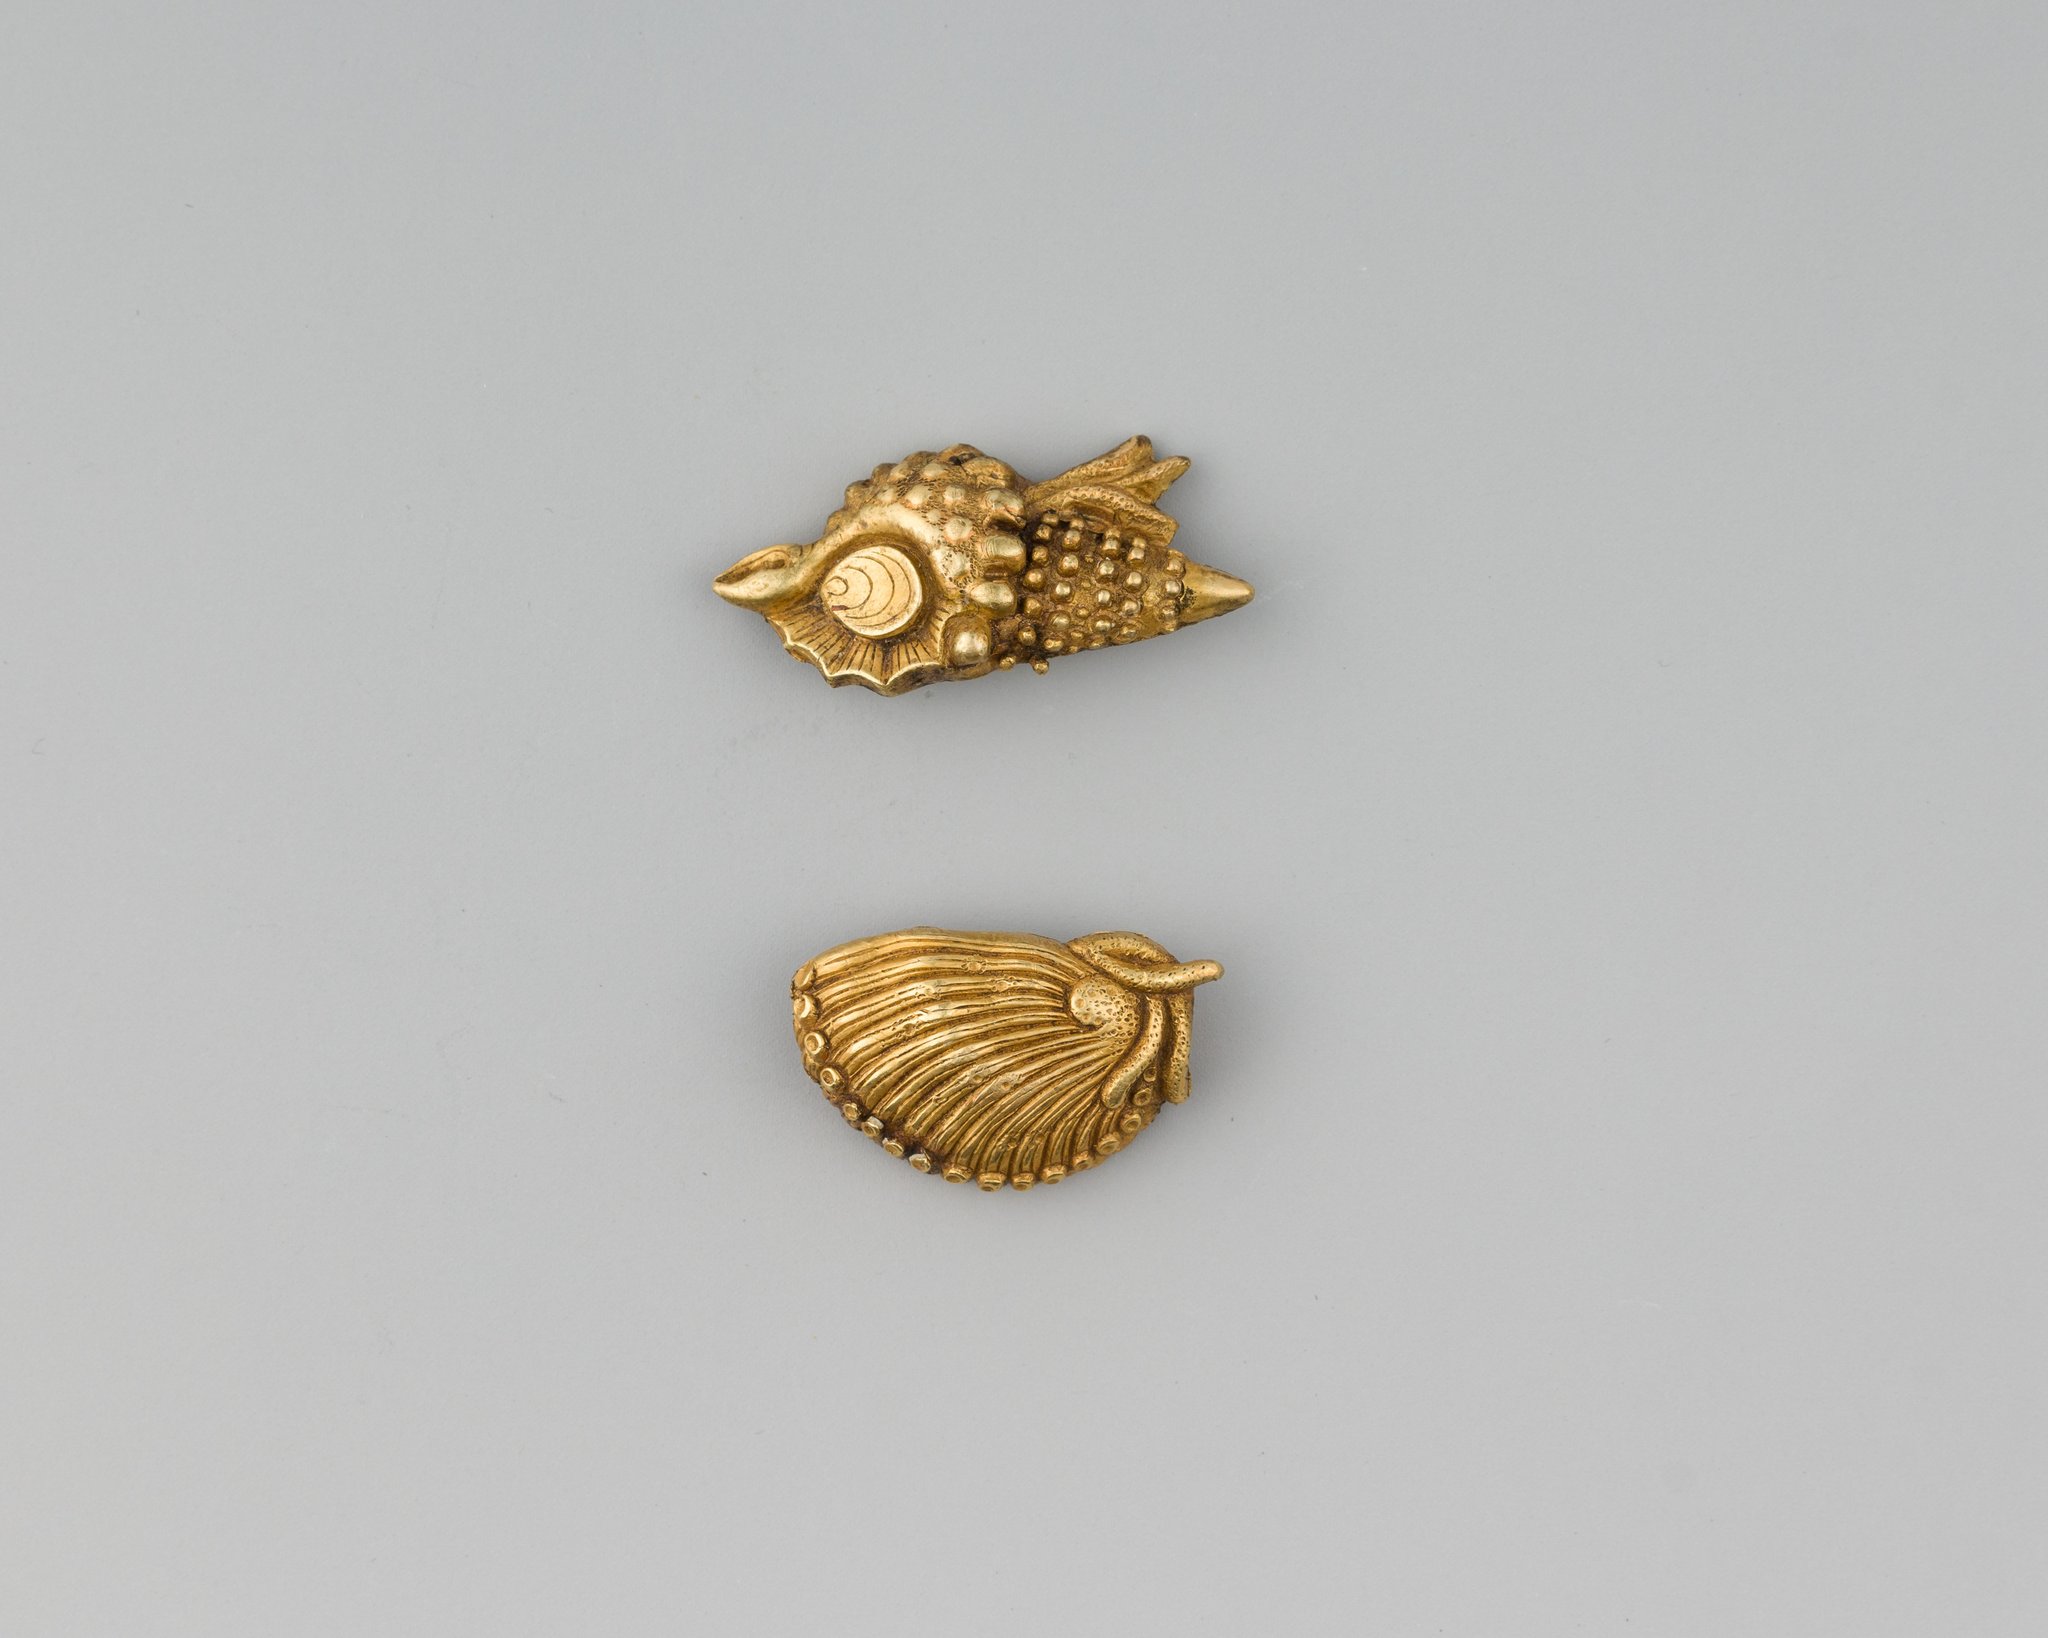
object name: pair of sword grip ornament menuki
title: Pair of Sword-Grip Ornaments (Menuki)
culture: japanese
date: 1701-1800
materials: gold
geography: japan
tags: snails,shells